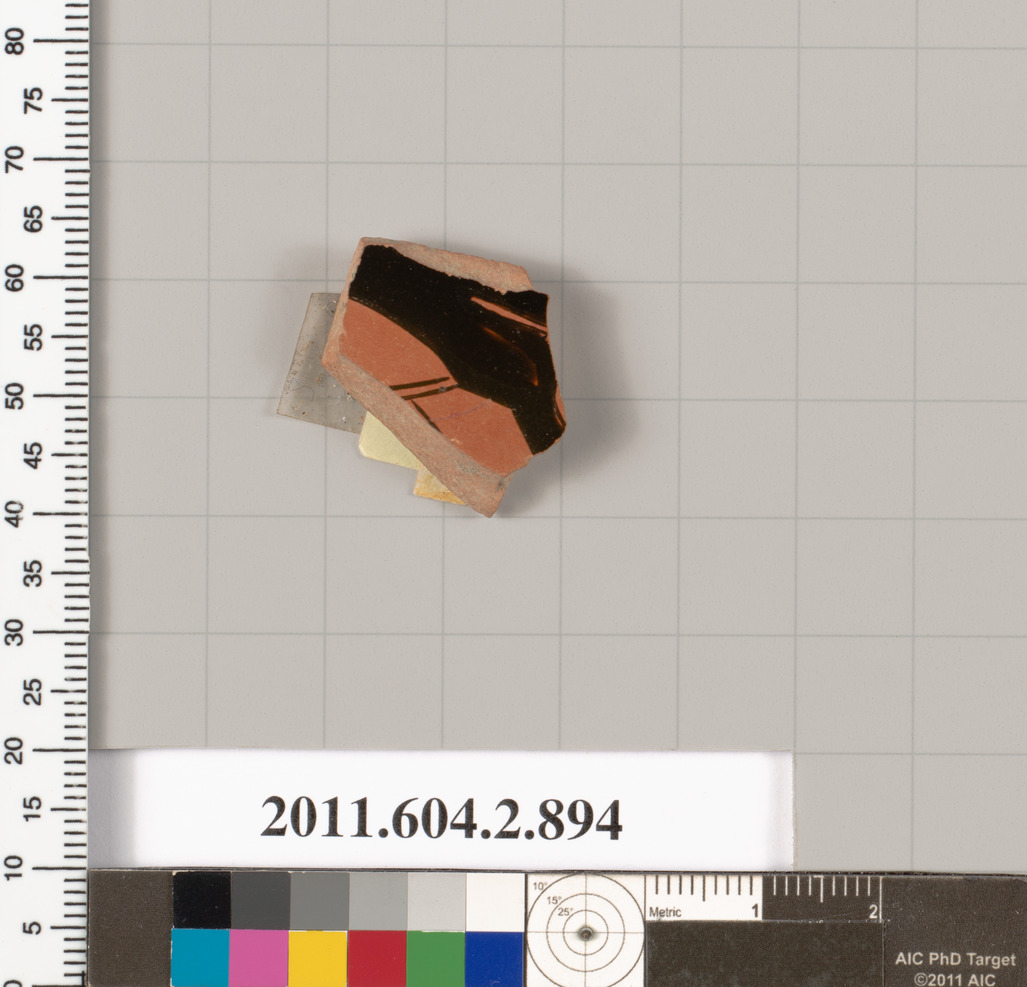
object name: bell krater fragment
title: Terracotta fragment of a bell-krater (bowl for mixing wine and water)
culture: greek, attic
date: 470-450 BCE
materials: terracotta